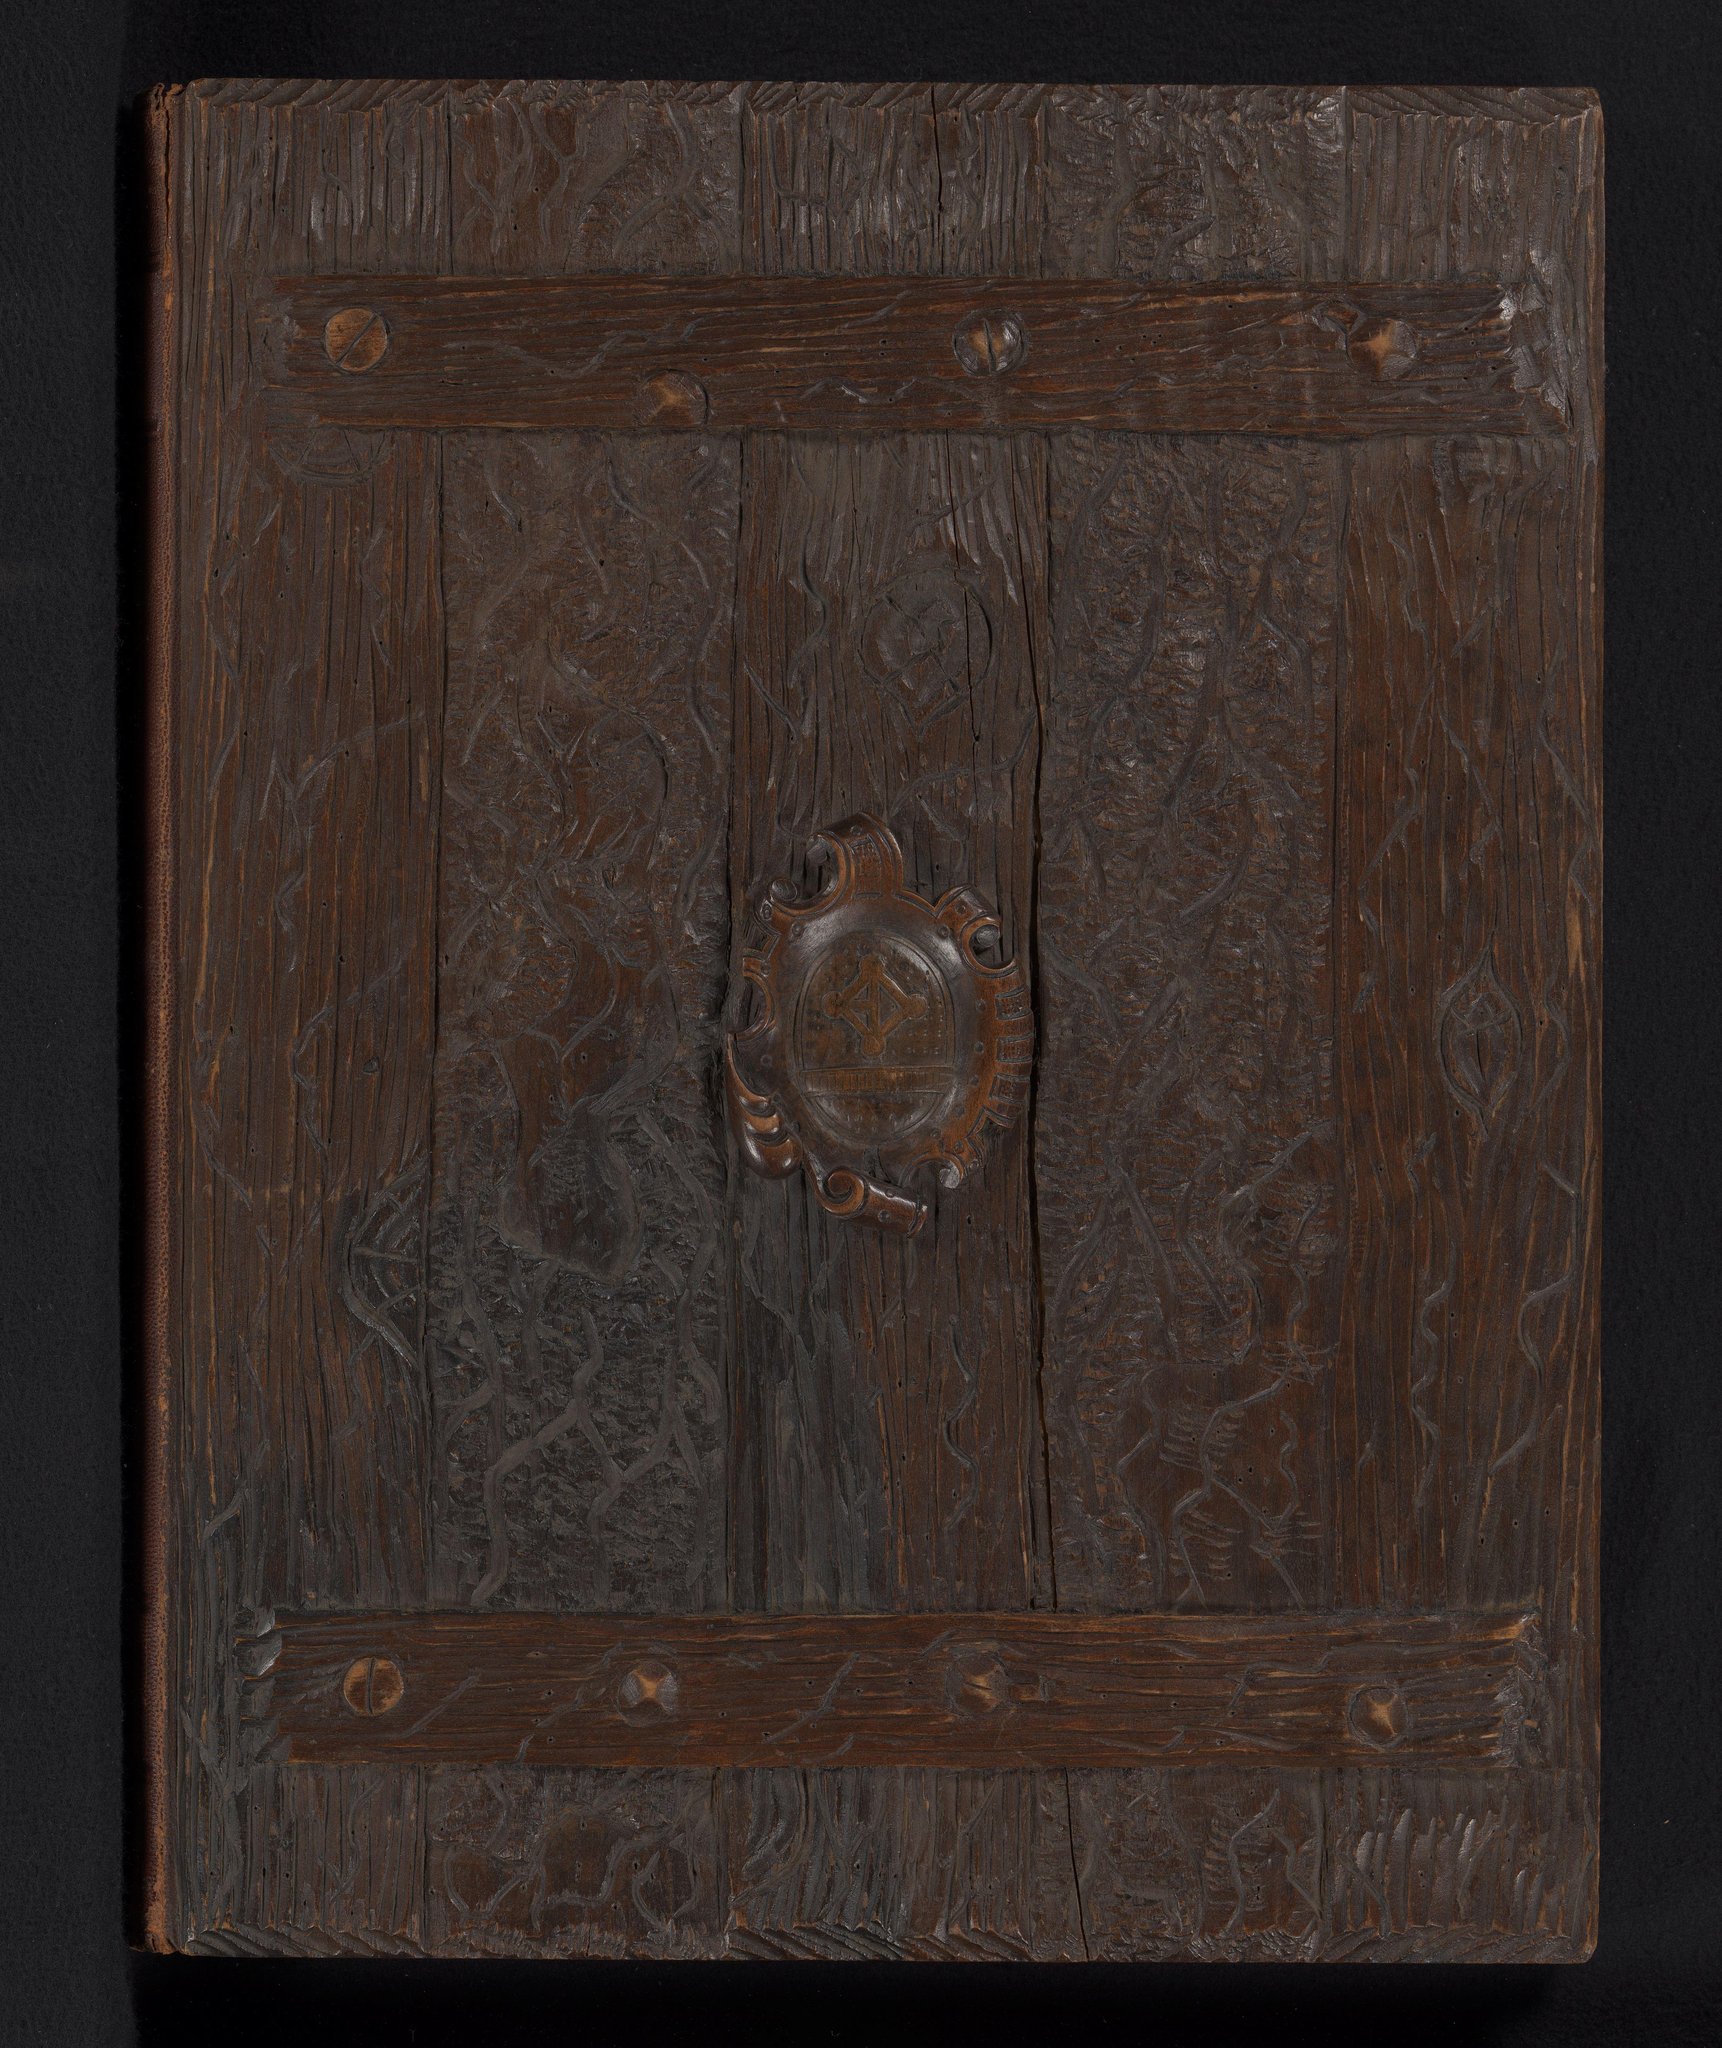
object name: photograph album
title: Herdenkingsalbum voor Carl von Bodelschwingh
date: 1860-1875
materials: paper, leather, paint, silk, wood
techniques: albumen print, drawing, moire, retouching, carving, writing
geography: germany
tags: berlin, minister ~ government, adult man, civic architecture; edifices; dwellings, street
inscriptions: company name: ‘C.W. Vogt & Sohn/ Hofbuchbinder/ Sr. Majestät d. Königs/ Berlin, Koch-Str. No. 7.’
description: Herdenkingsalbum ter herinnering aan de Pruisische minister van financiën Carl von Bodelschwingh met 21 foto's van plaatsen uit zijn leven en drie portretten van hemzelf en zijn zonen. Ruimschoots versierd met decoraties, bijschriften en Bijbelspreuken. Van alle foto's is de fotograaf anoniem.